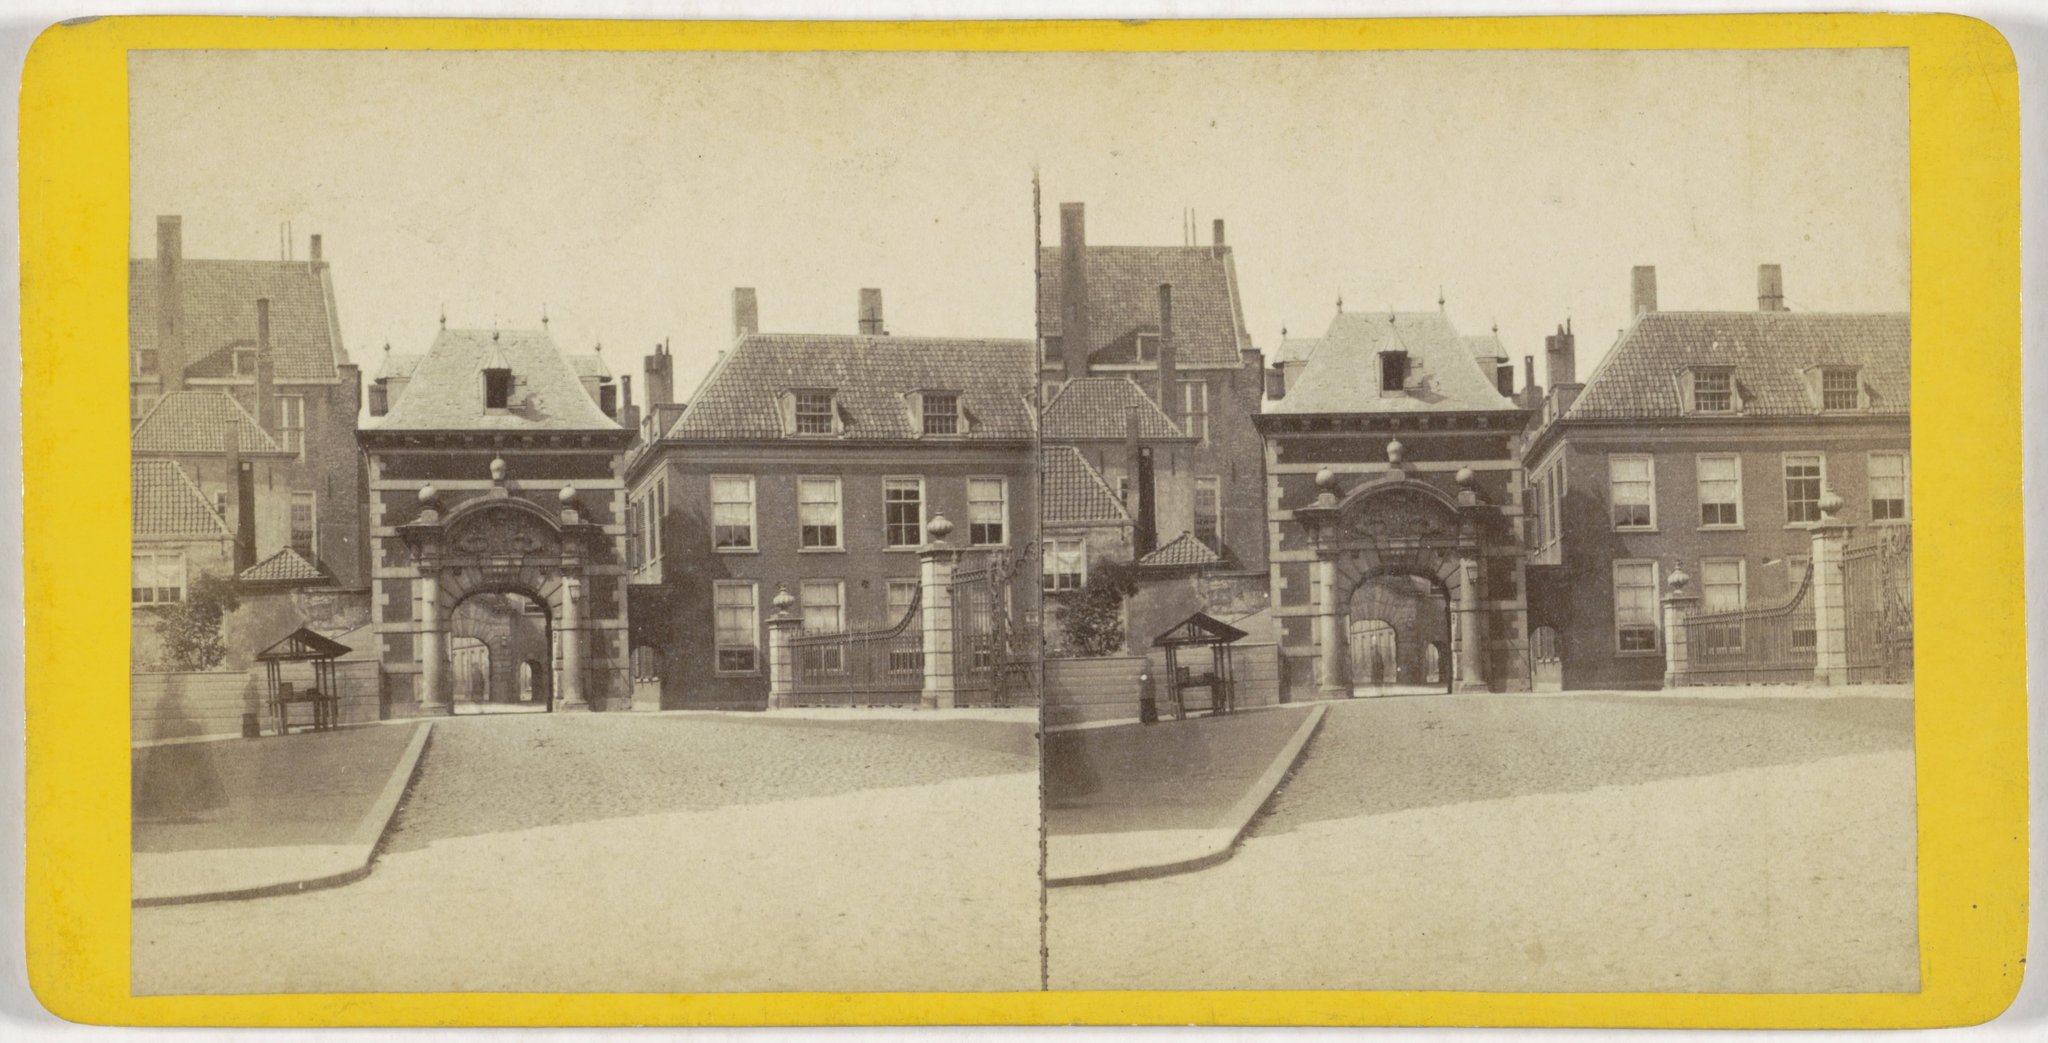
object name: stereograph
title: Den Haag, Binnenhof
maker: Anonymous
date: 1873-1890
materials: cardboard, paper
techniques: albumen print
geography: the hague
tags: gate, entrance, lower house, parliament, chamber